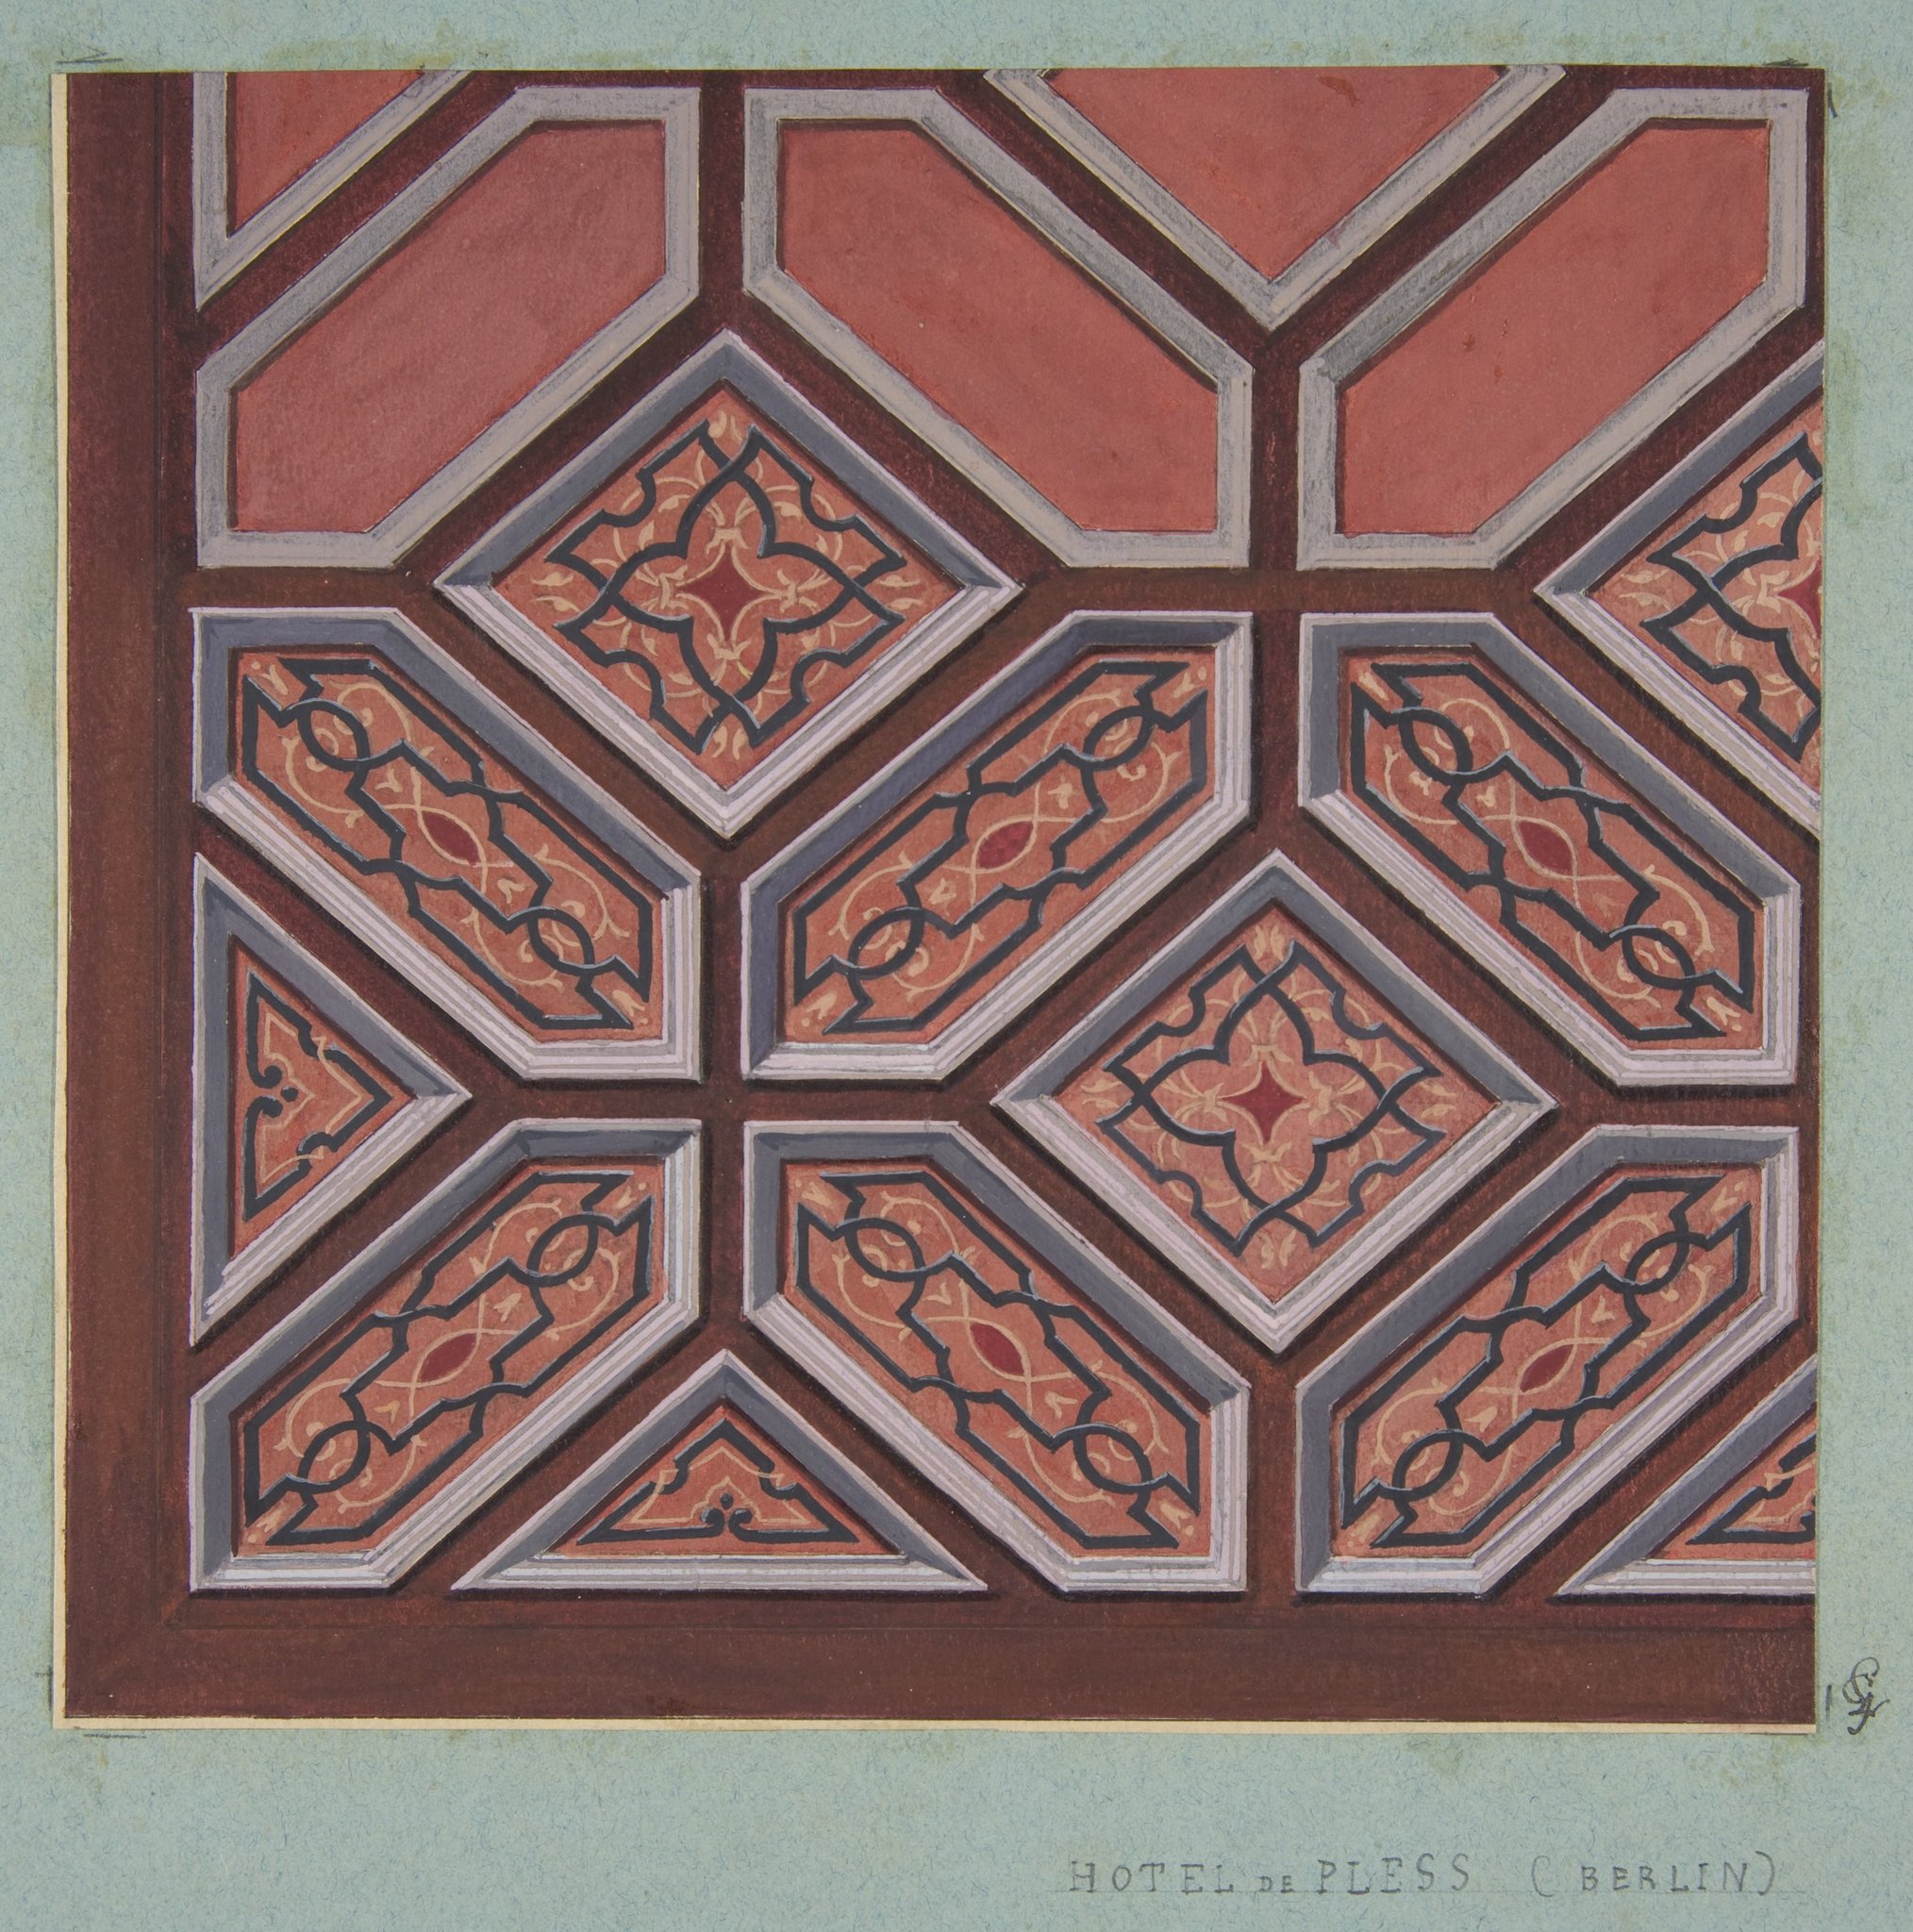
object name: drawing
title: Design for Ceiling Decoration Hôtel de Pless, Berlin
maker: jules-edmond-charles lachaise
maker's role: artist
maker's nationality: french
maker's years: 1897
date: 1851-1900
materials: gouache, watercolor, paper